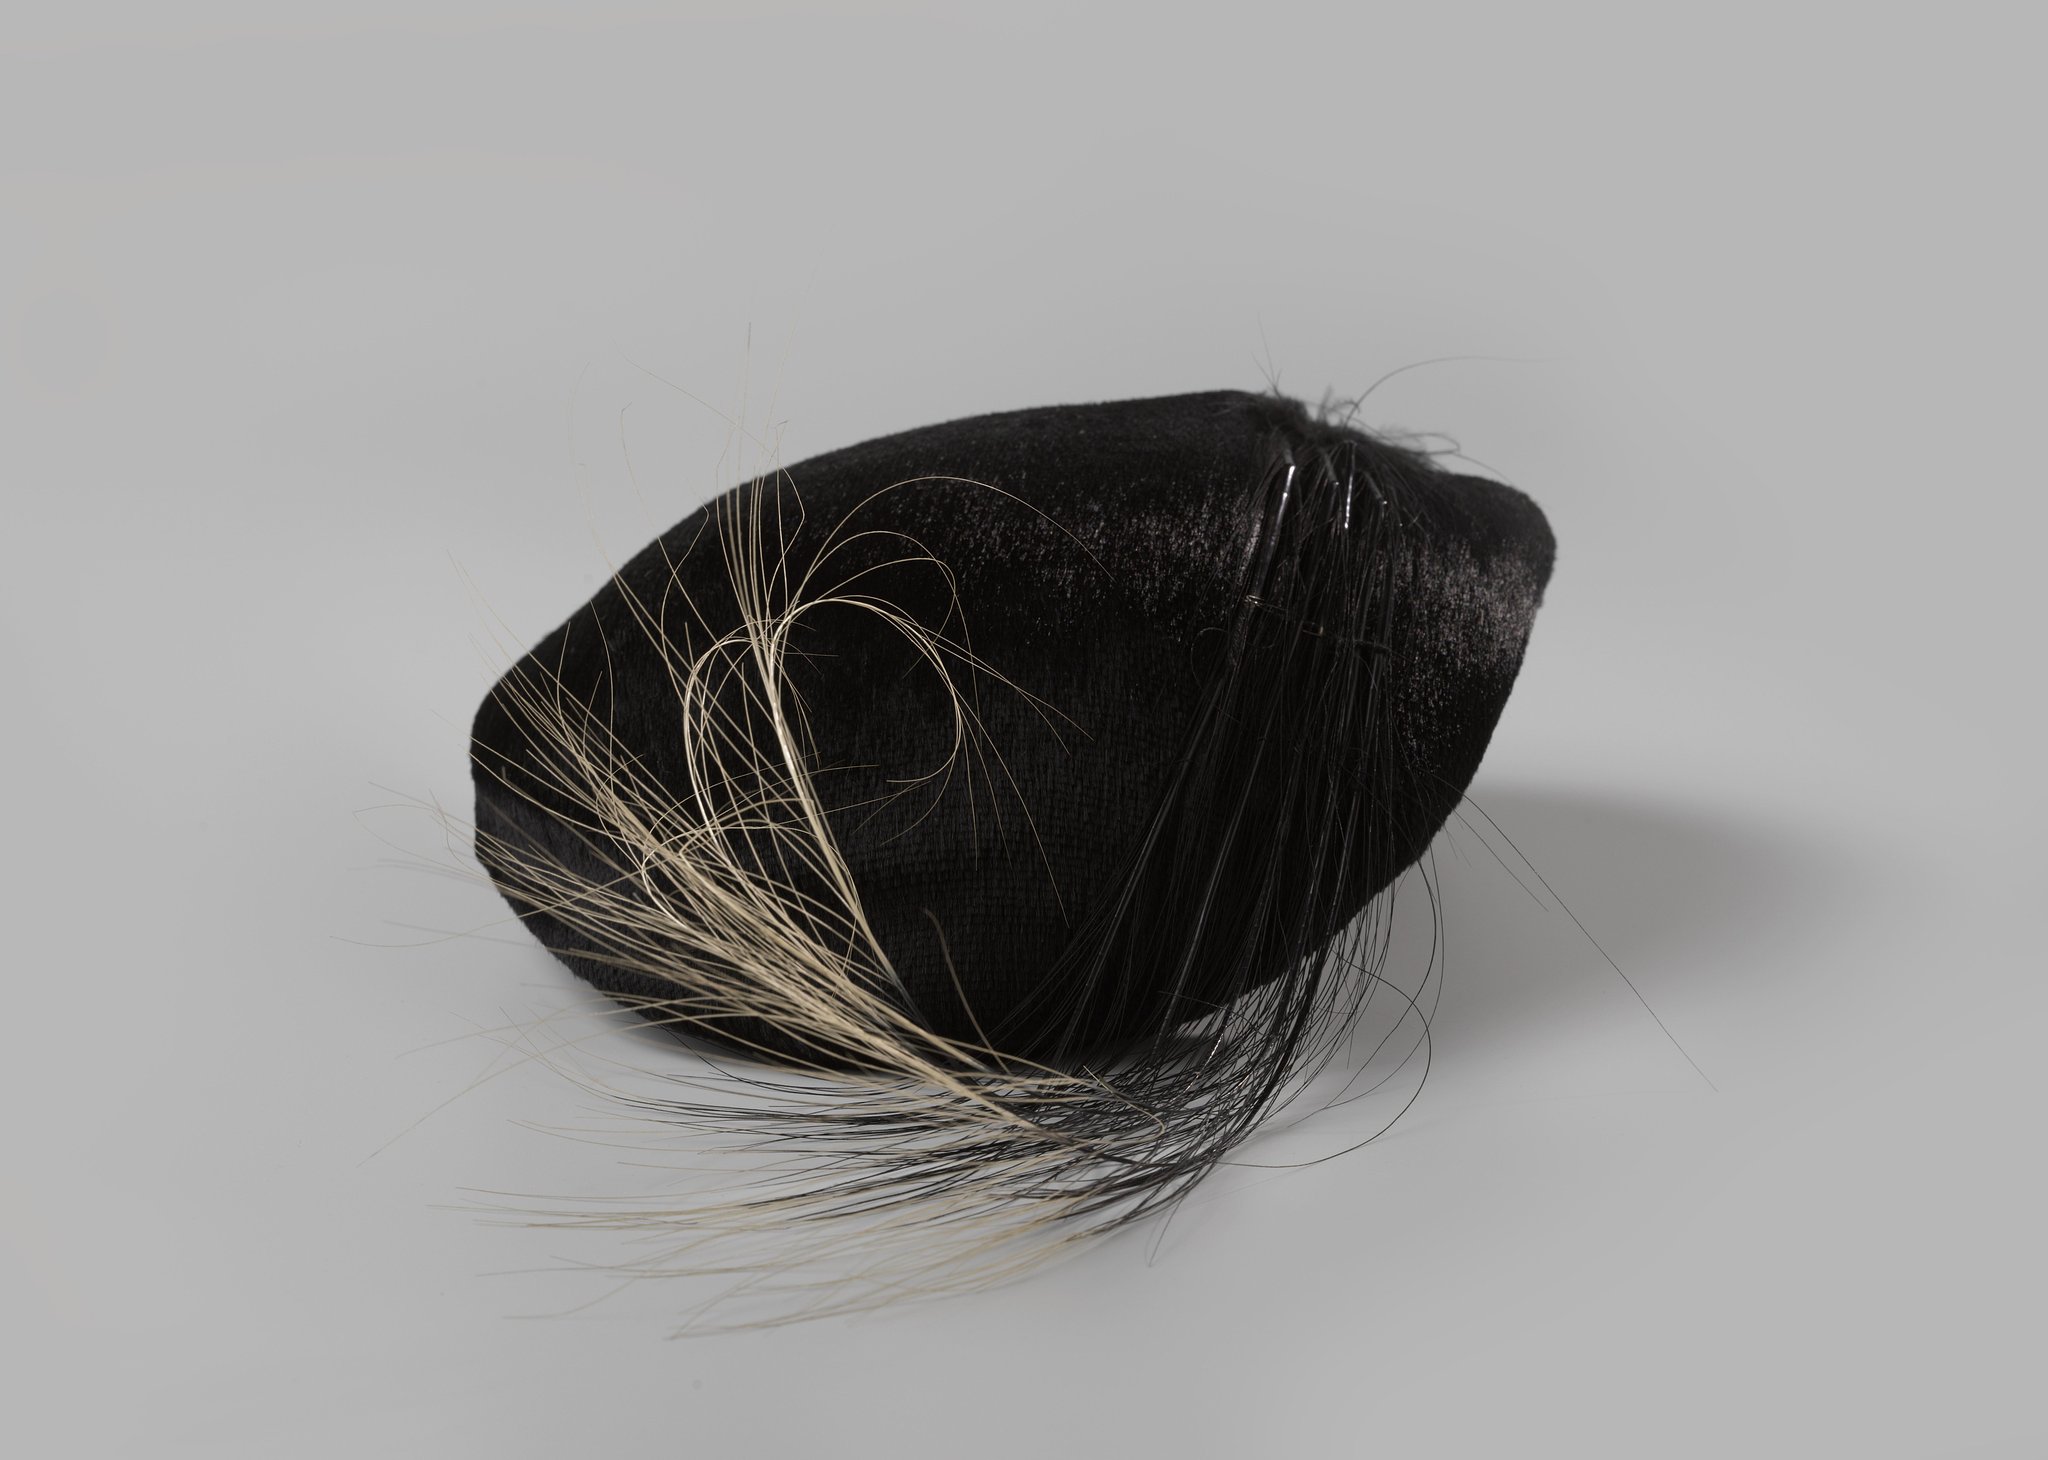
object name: womenswear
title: Hoedje van zwart castor, of zijden fluweel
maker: Anonymous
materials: feather, silk, velvet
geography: amsterdam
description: Hoedje van zwart castor, of zijden fluweel (?). Gekleed model, ondiepe, weinig gebogen doosvorm, alleen van voren een staande naar binnen gebogen wand, hoger dan van achter. Rechts glad aflopend. Naar rechts gelegde, breed uitstaande aigrette of paradijsveer (?) van zwart en wit, omhooggebogen krullen. Voering van zwarte moirézijde.